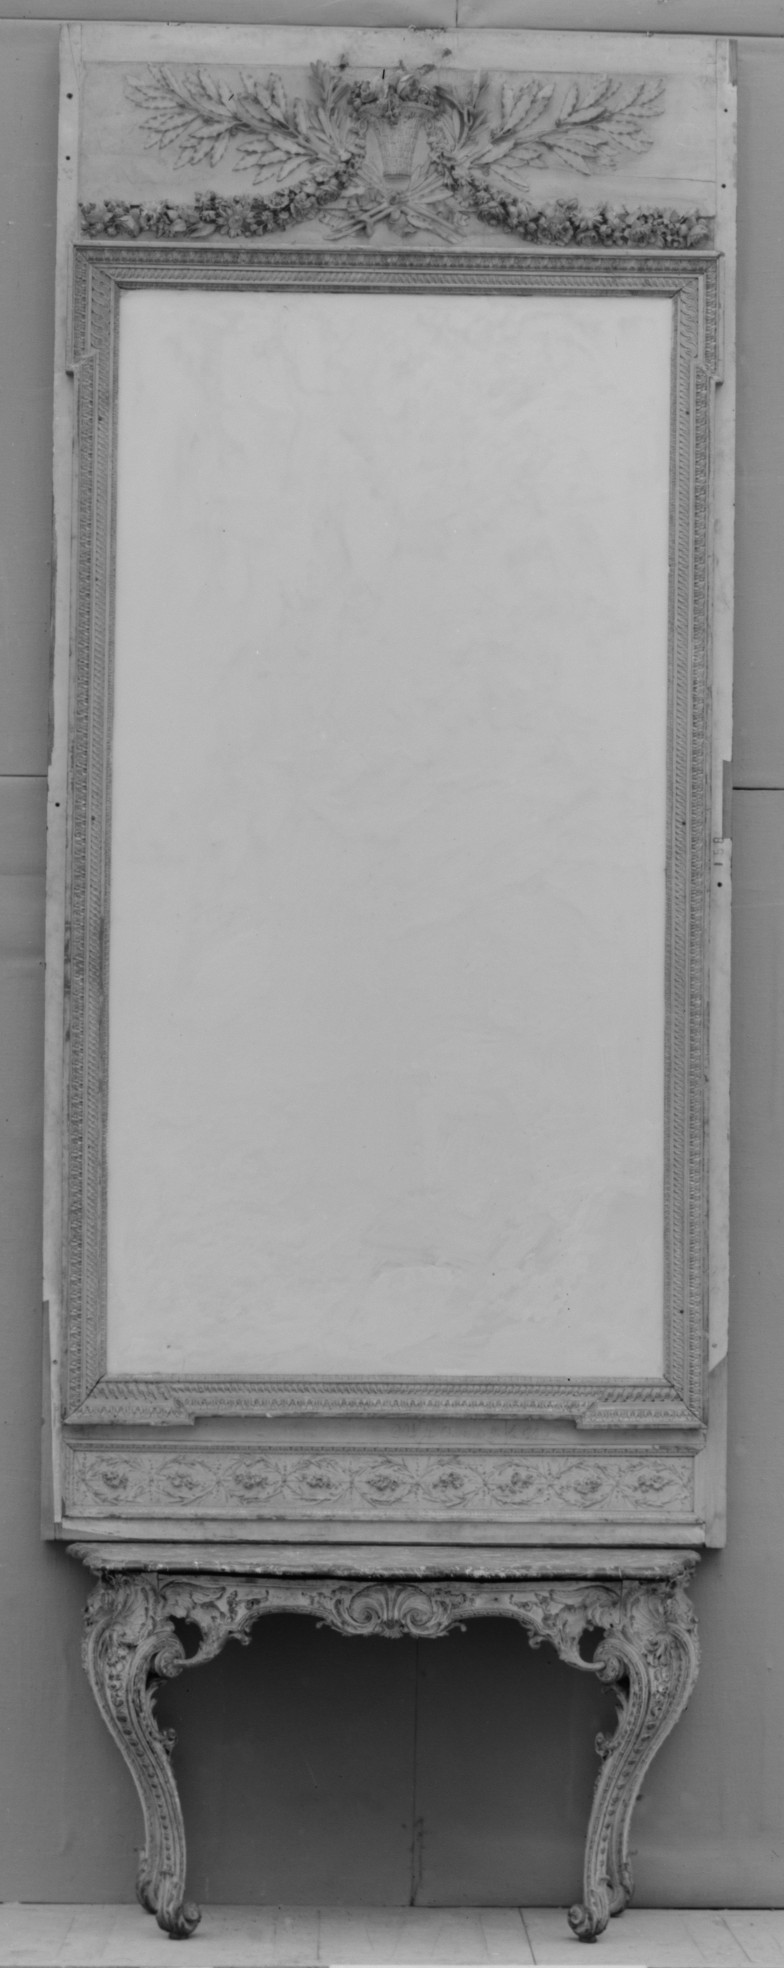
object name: pier glass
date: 1701-1800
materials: wood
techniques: painting